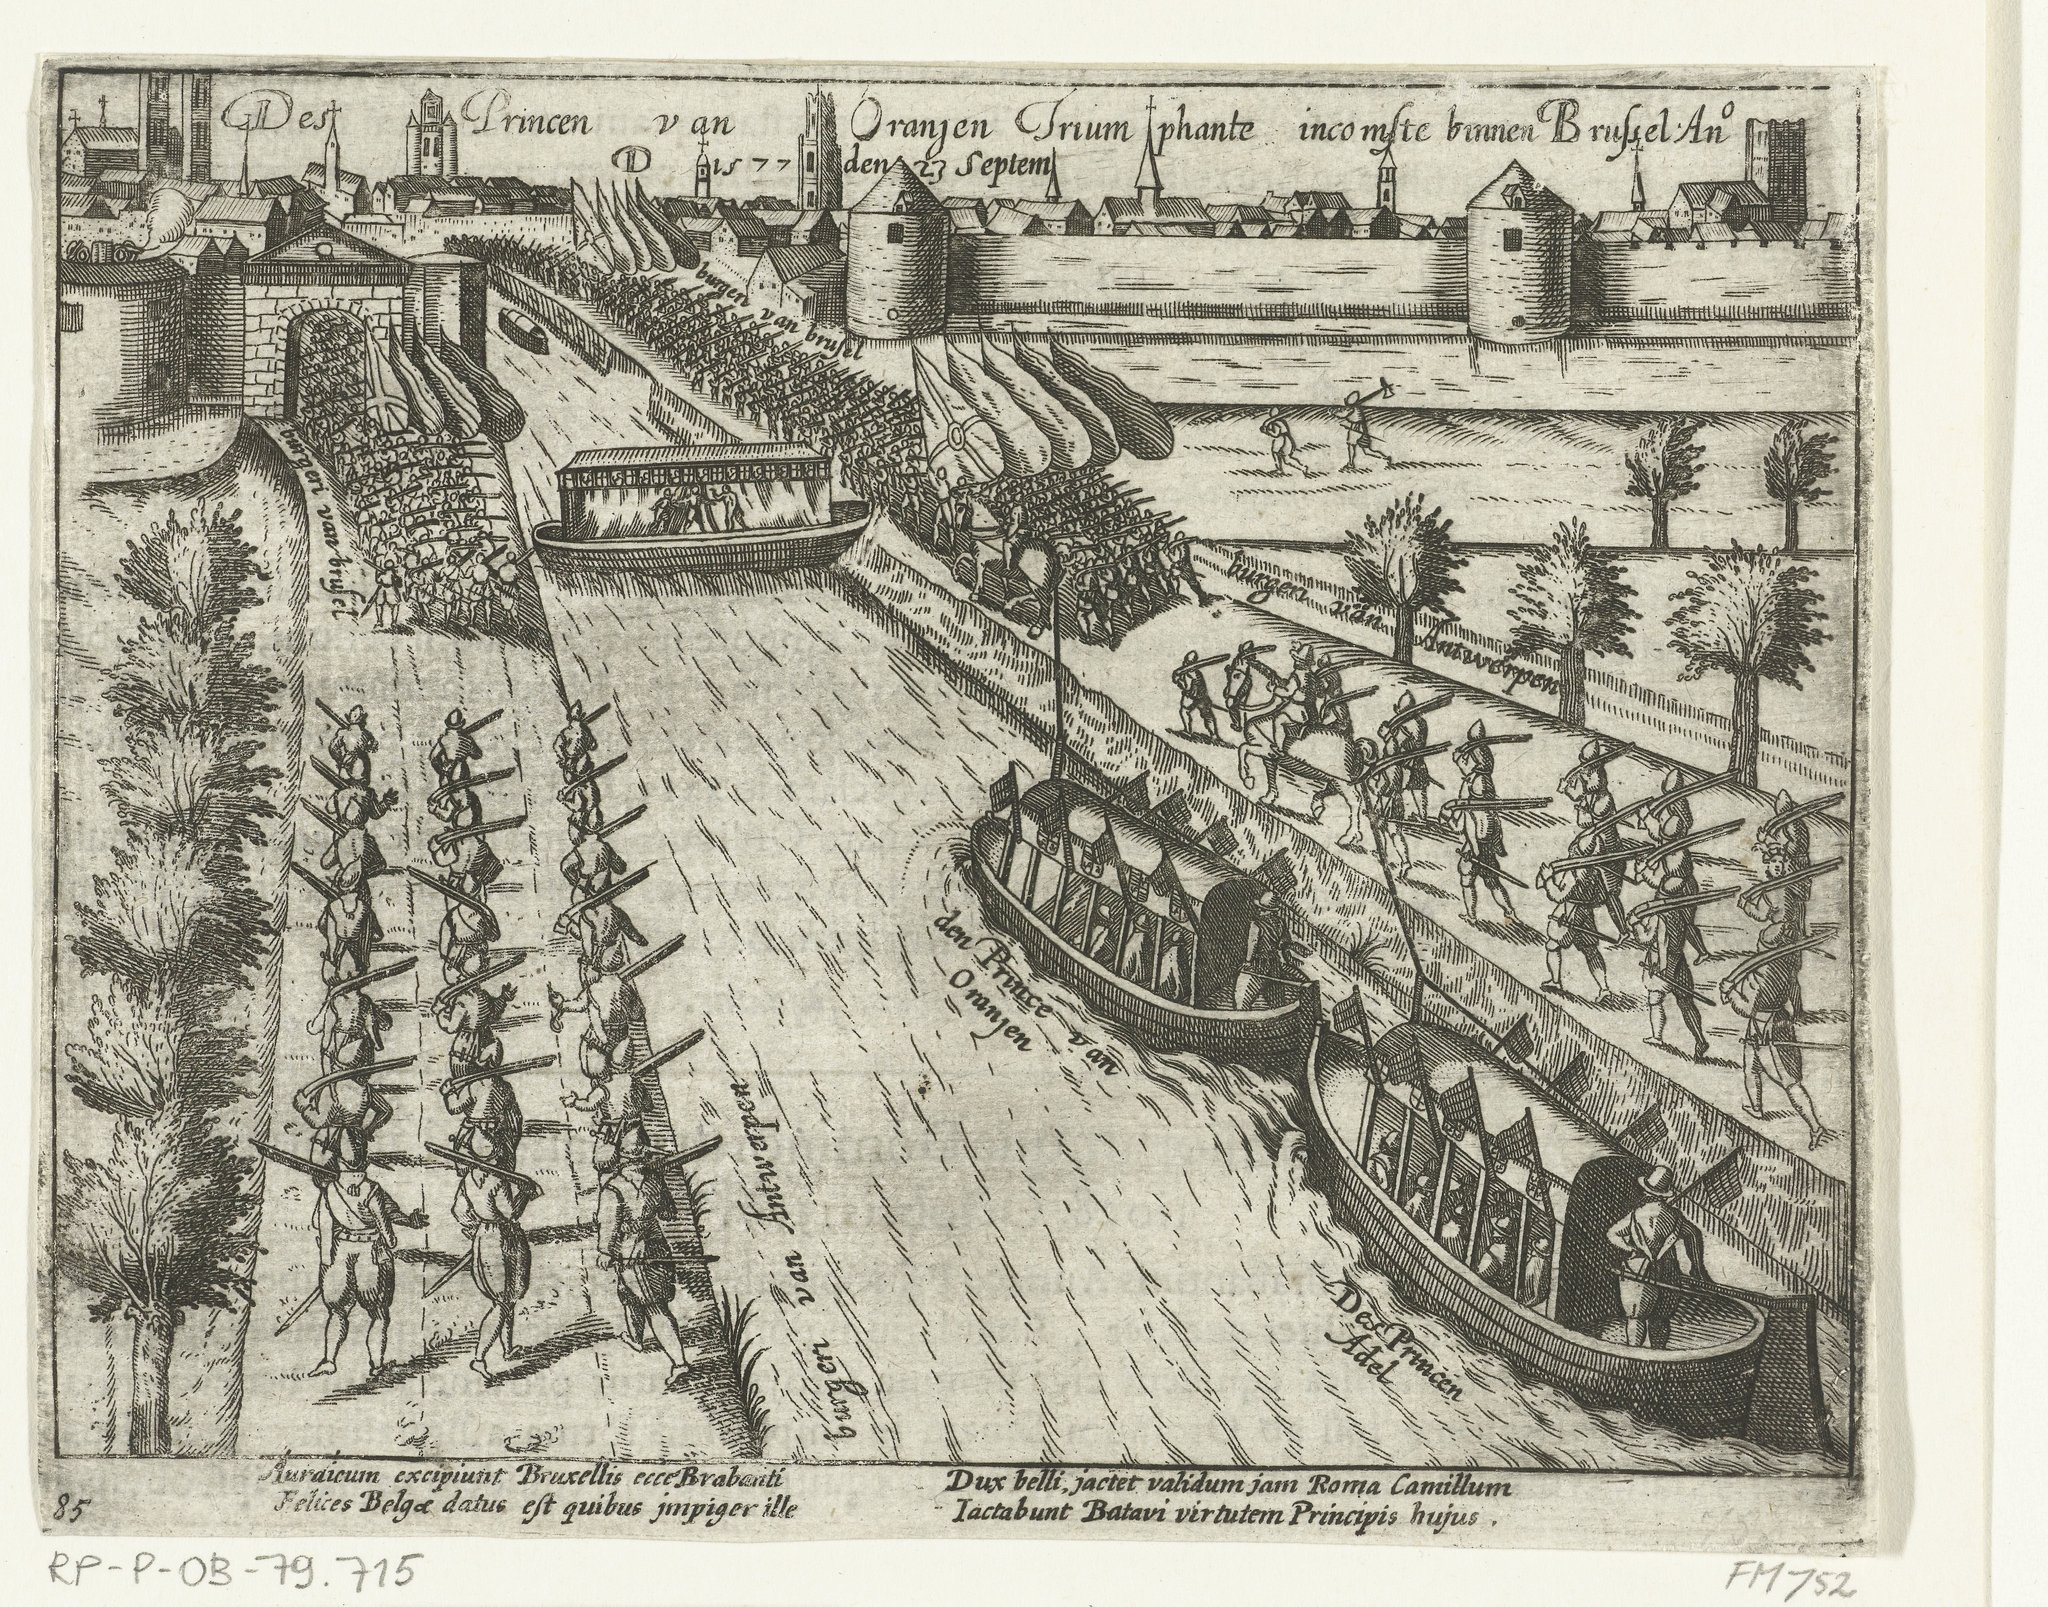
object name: print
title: Intocht van de prins van Oranje te Brussel, 1577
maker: Anonymous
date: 1613-1615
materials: paper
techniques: etching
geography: northern netherlands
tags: delft, william i (prince of orange), triumphal entry and public reception, pageant, 'entrée solennelle', 'joyeuse entrée', brussels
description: Feestelijke intocht van de prins van Oranje te Brussel, 23 september 1577. Oranje in een trekschuit en begeleid door ruiters en soldaten uit Antwerpen en Brussel de stad ingeleid. Met onderschrift van 4 regels in het Latijn. Genummerd: 85. Bedrukt op achterzijde met tekst in het Latijn.